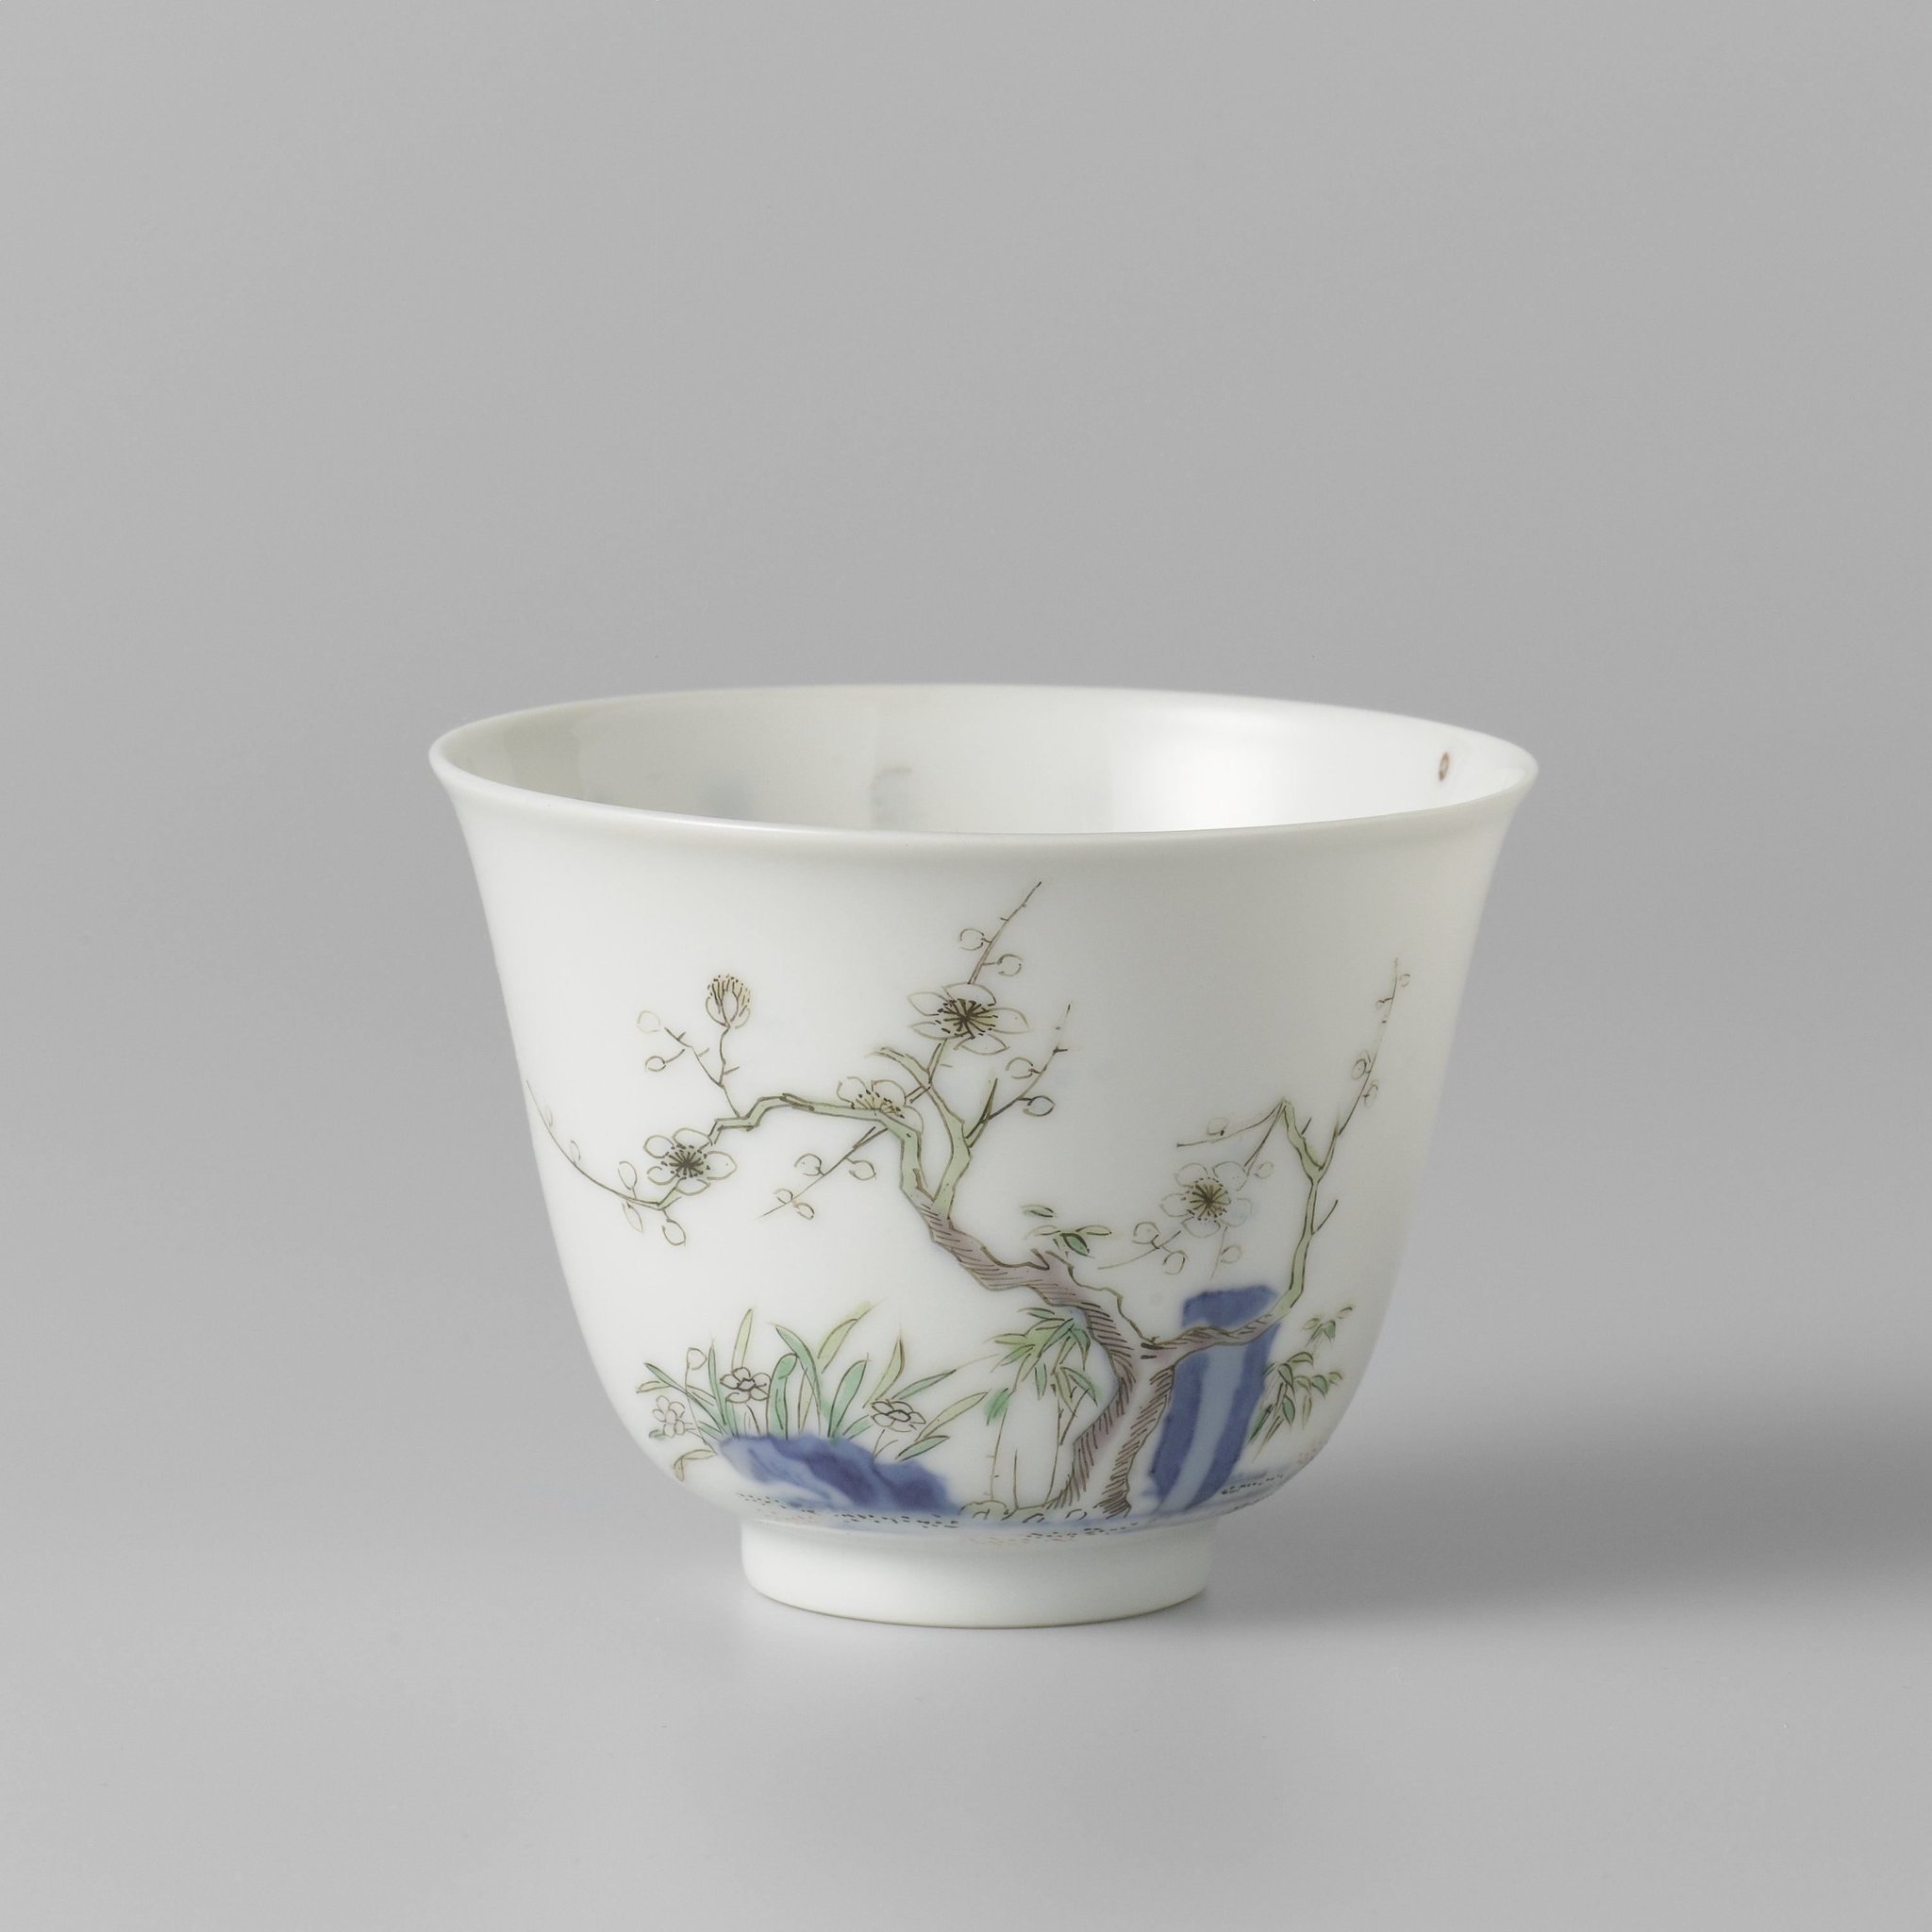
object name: cup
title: Month cup of the first month with a prunus tree and a poem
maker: Anonymous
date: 1700-1724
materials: cobalt, glaze, paint, porcelain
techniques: firing, turning, vitrification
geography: china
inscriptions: mark: ‘大 清 康 熙 年 製’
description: Klokvormige kop van porselein, beschilderd in onderglazuur blauw en op het glazuur blauw, rood, groen, geel, aubergine en zwart. Maandkopje van de eerste maand met op de buitenwand een prunusboom en een tweeregelig gedicht afgesloten door het zegelmerk 'shang', waardering. Gemerkt op de onderzijde met het zes-karaktermerk van keizer Kangxi in een dubbele cirkel. Porselein met emailkleuren.